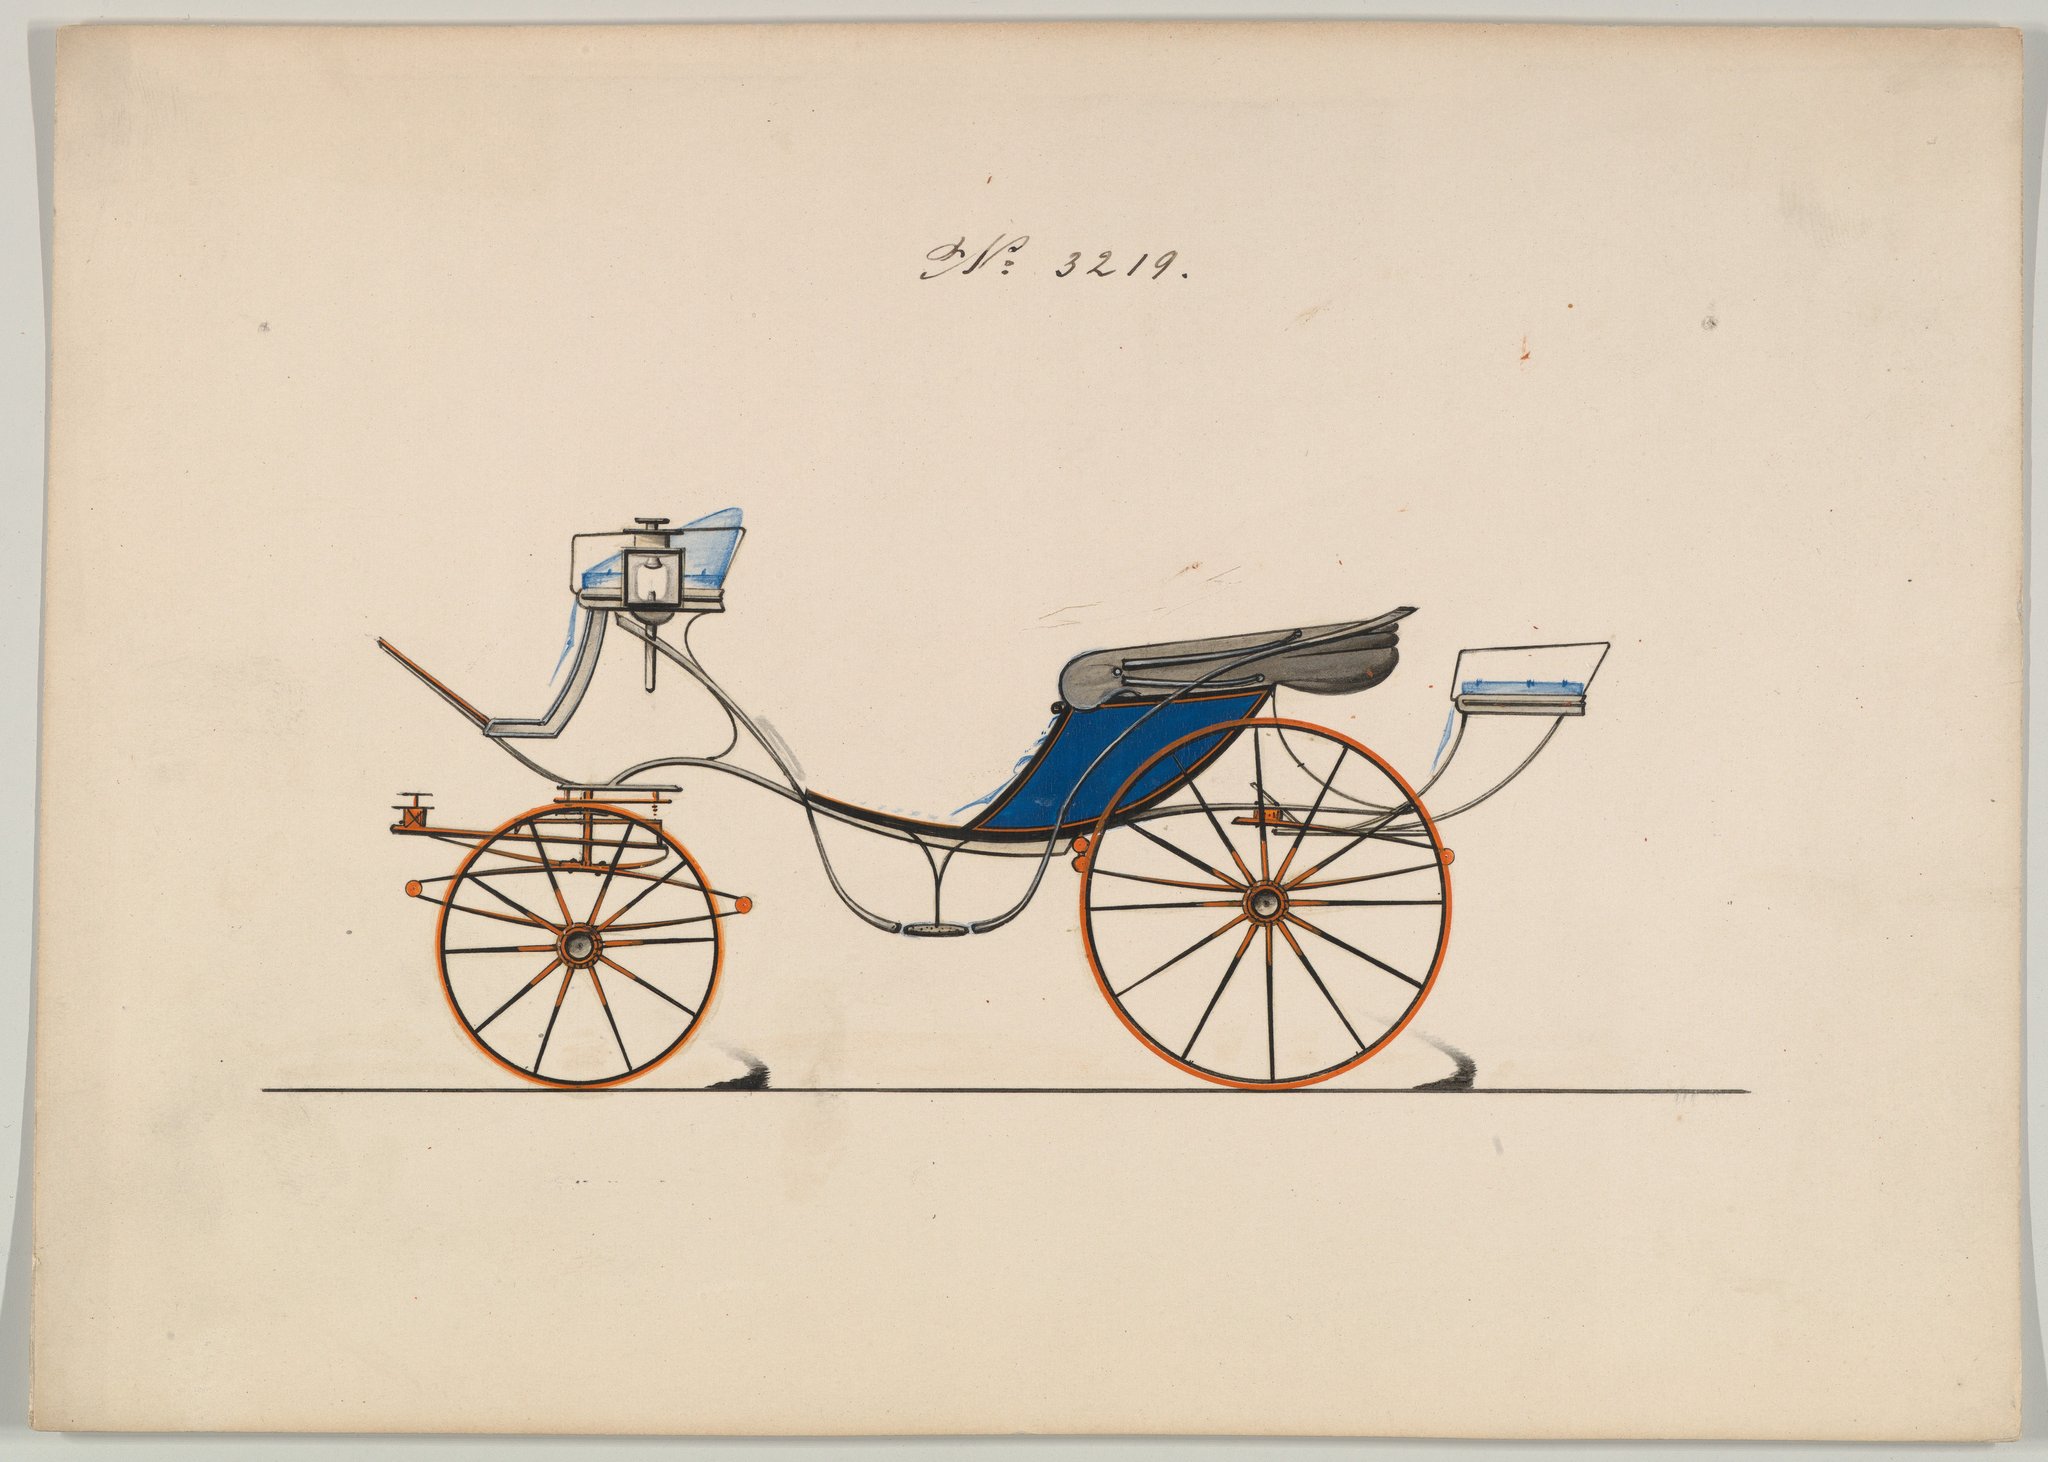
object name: drawing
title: Cabriolet #3219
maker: brewster & co.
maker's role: manufacturer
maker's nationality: american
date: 1876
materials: gouache, gum arabic, ink, watercolor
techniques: pen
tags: carriages